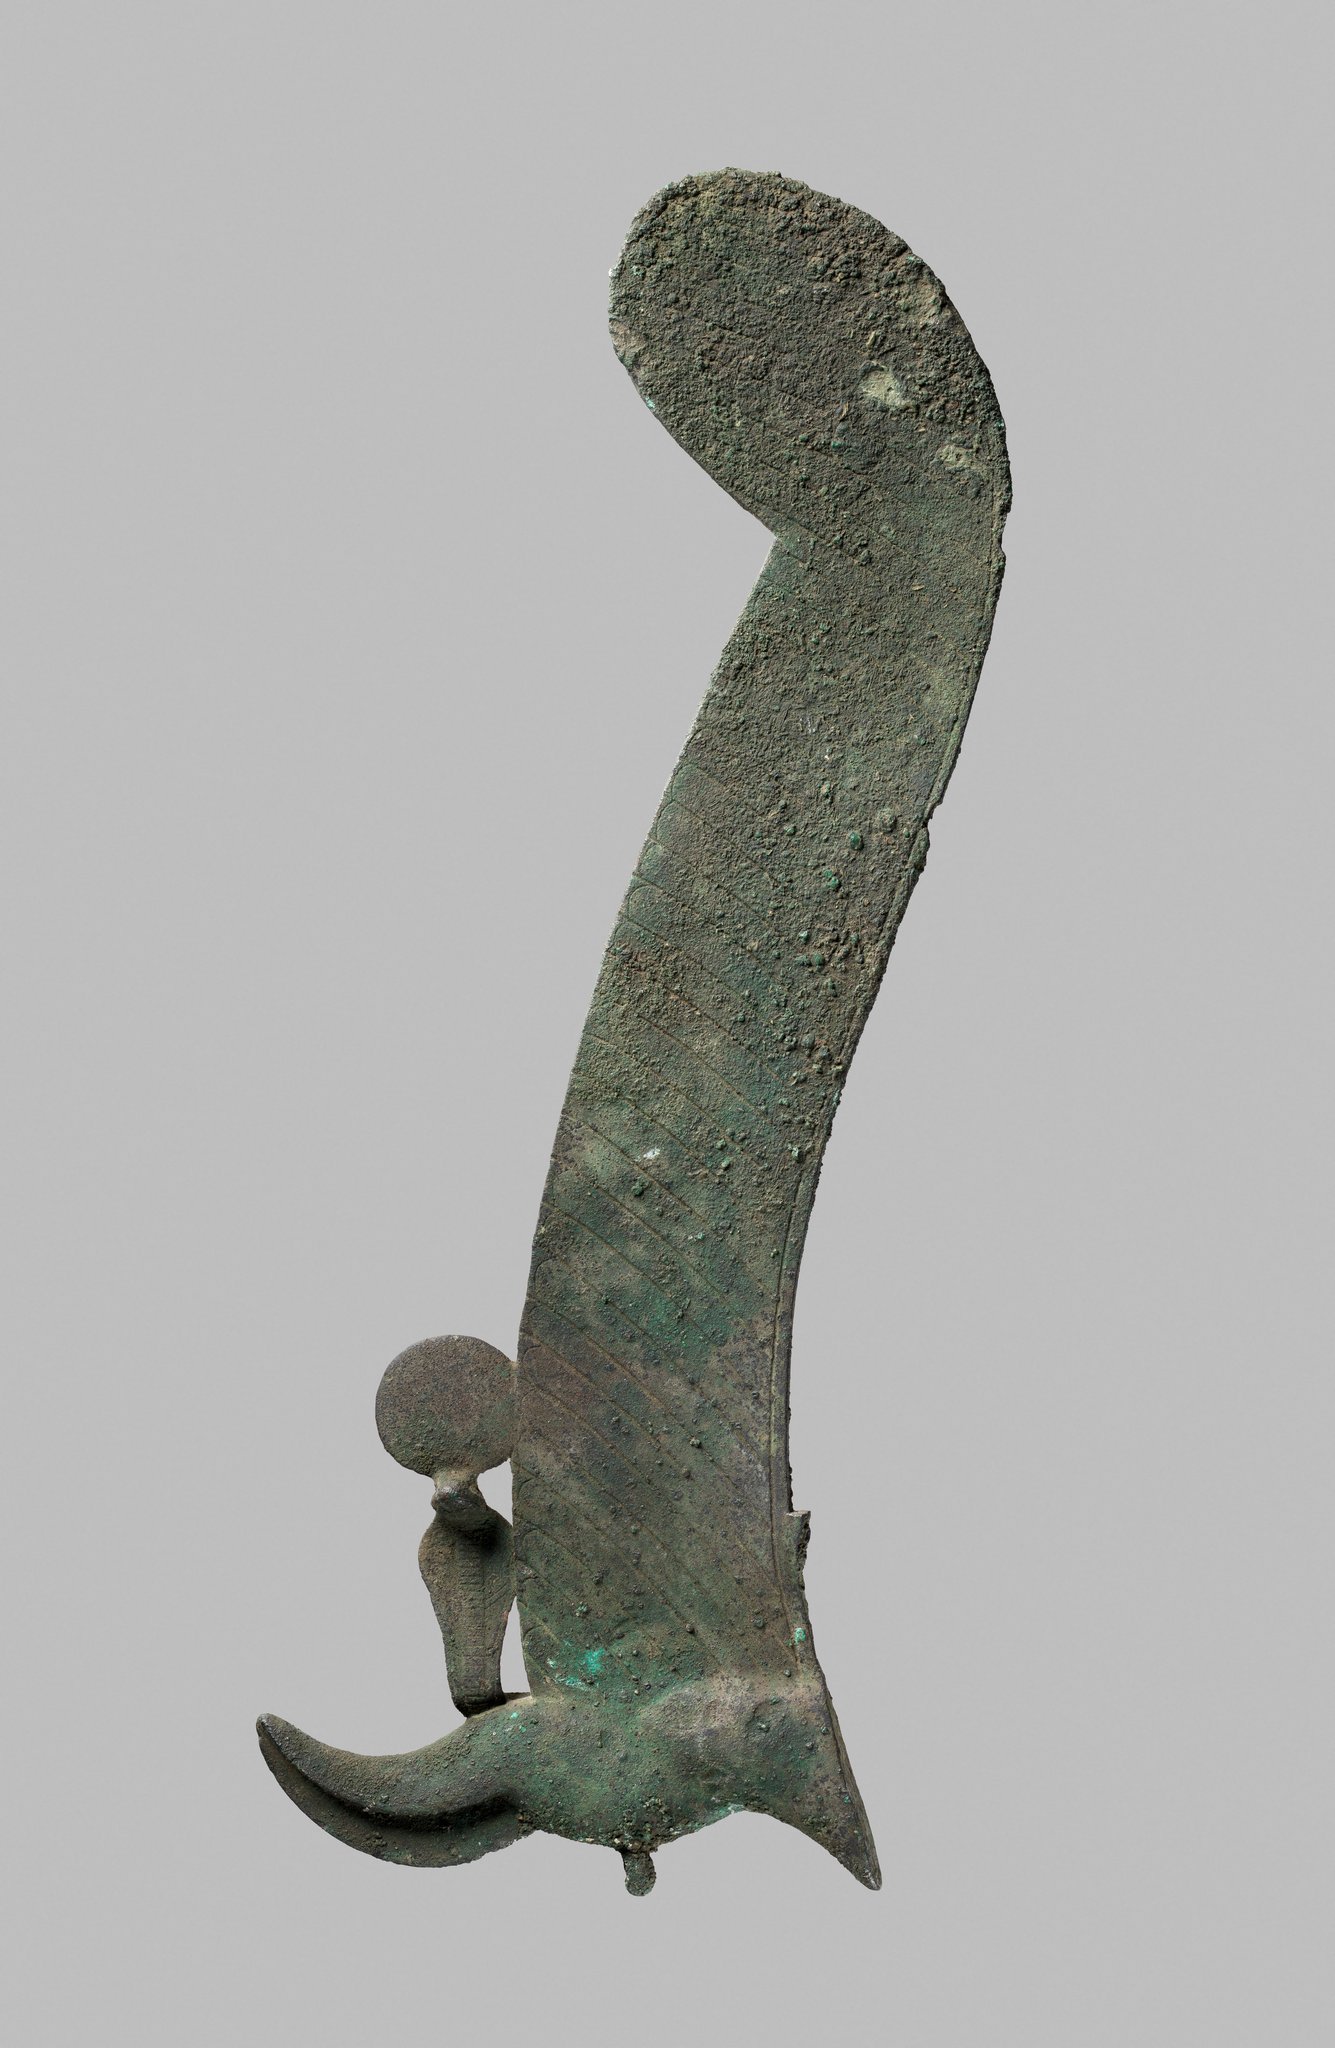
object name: headdress attachment, feather, osiris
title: Feather and uraeus attachment for the crown of a large statue of Osiris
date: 664-332 BCE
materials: bronze, copper alloy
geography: egypt